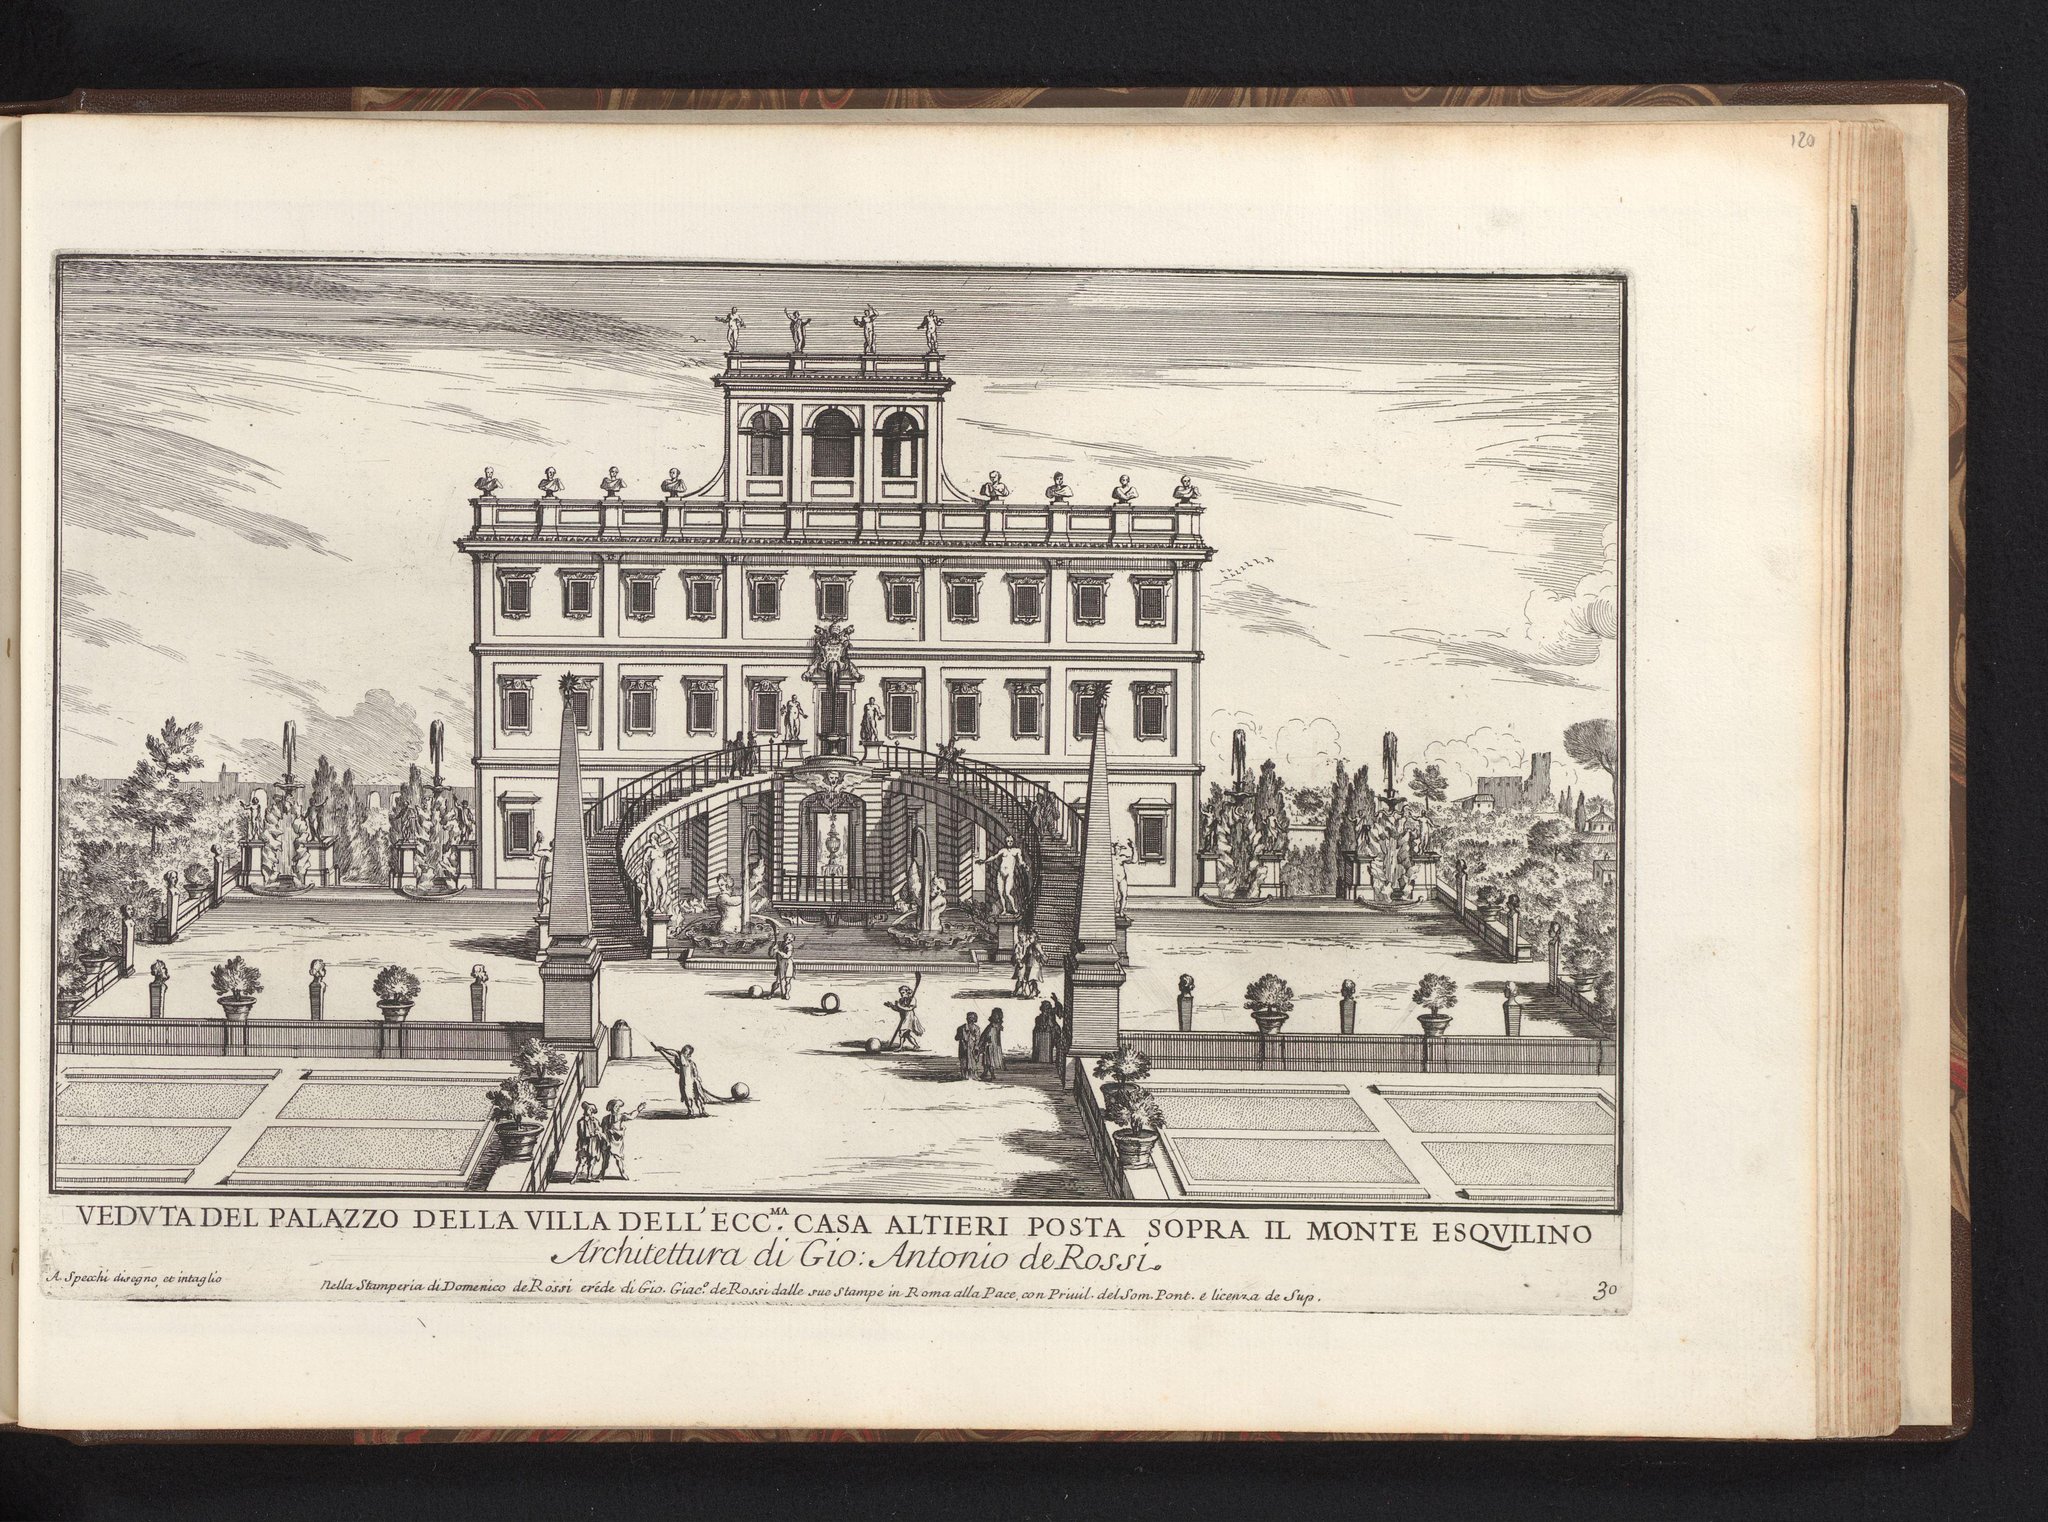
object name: album leaf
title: Il nuovo teatro di Roma moderna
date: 1699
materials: paper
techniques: etching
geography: italy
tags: city-view, and landscape with man-made constructions, villa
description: Deze prent maakt deel uit van een reeks van 52 prenten met voorstellingen van paleizen in Rome. Samen met vier andere reeksen vormt het de grote reeks: 'Il nuovo teatro di Roma moderna'.